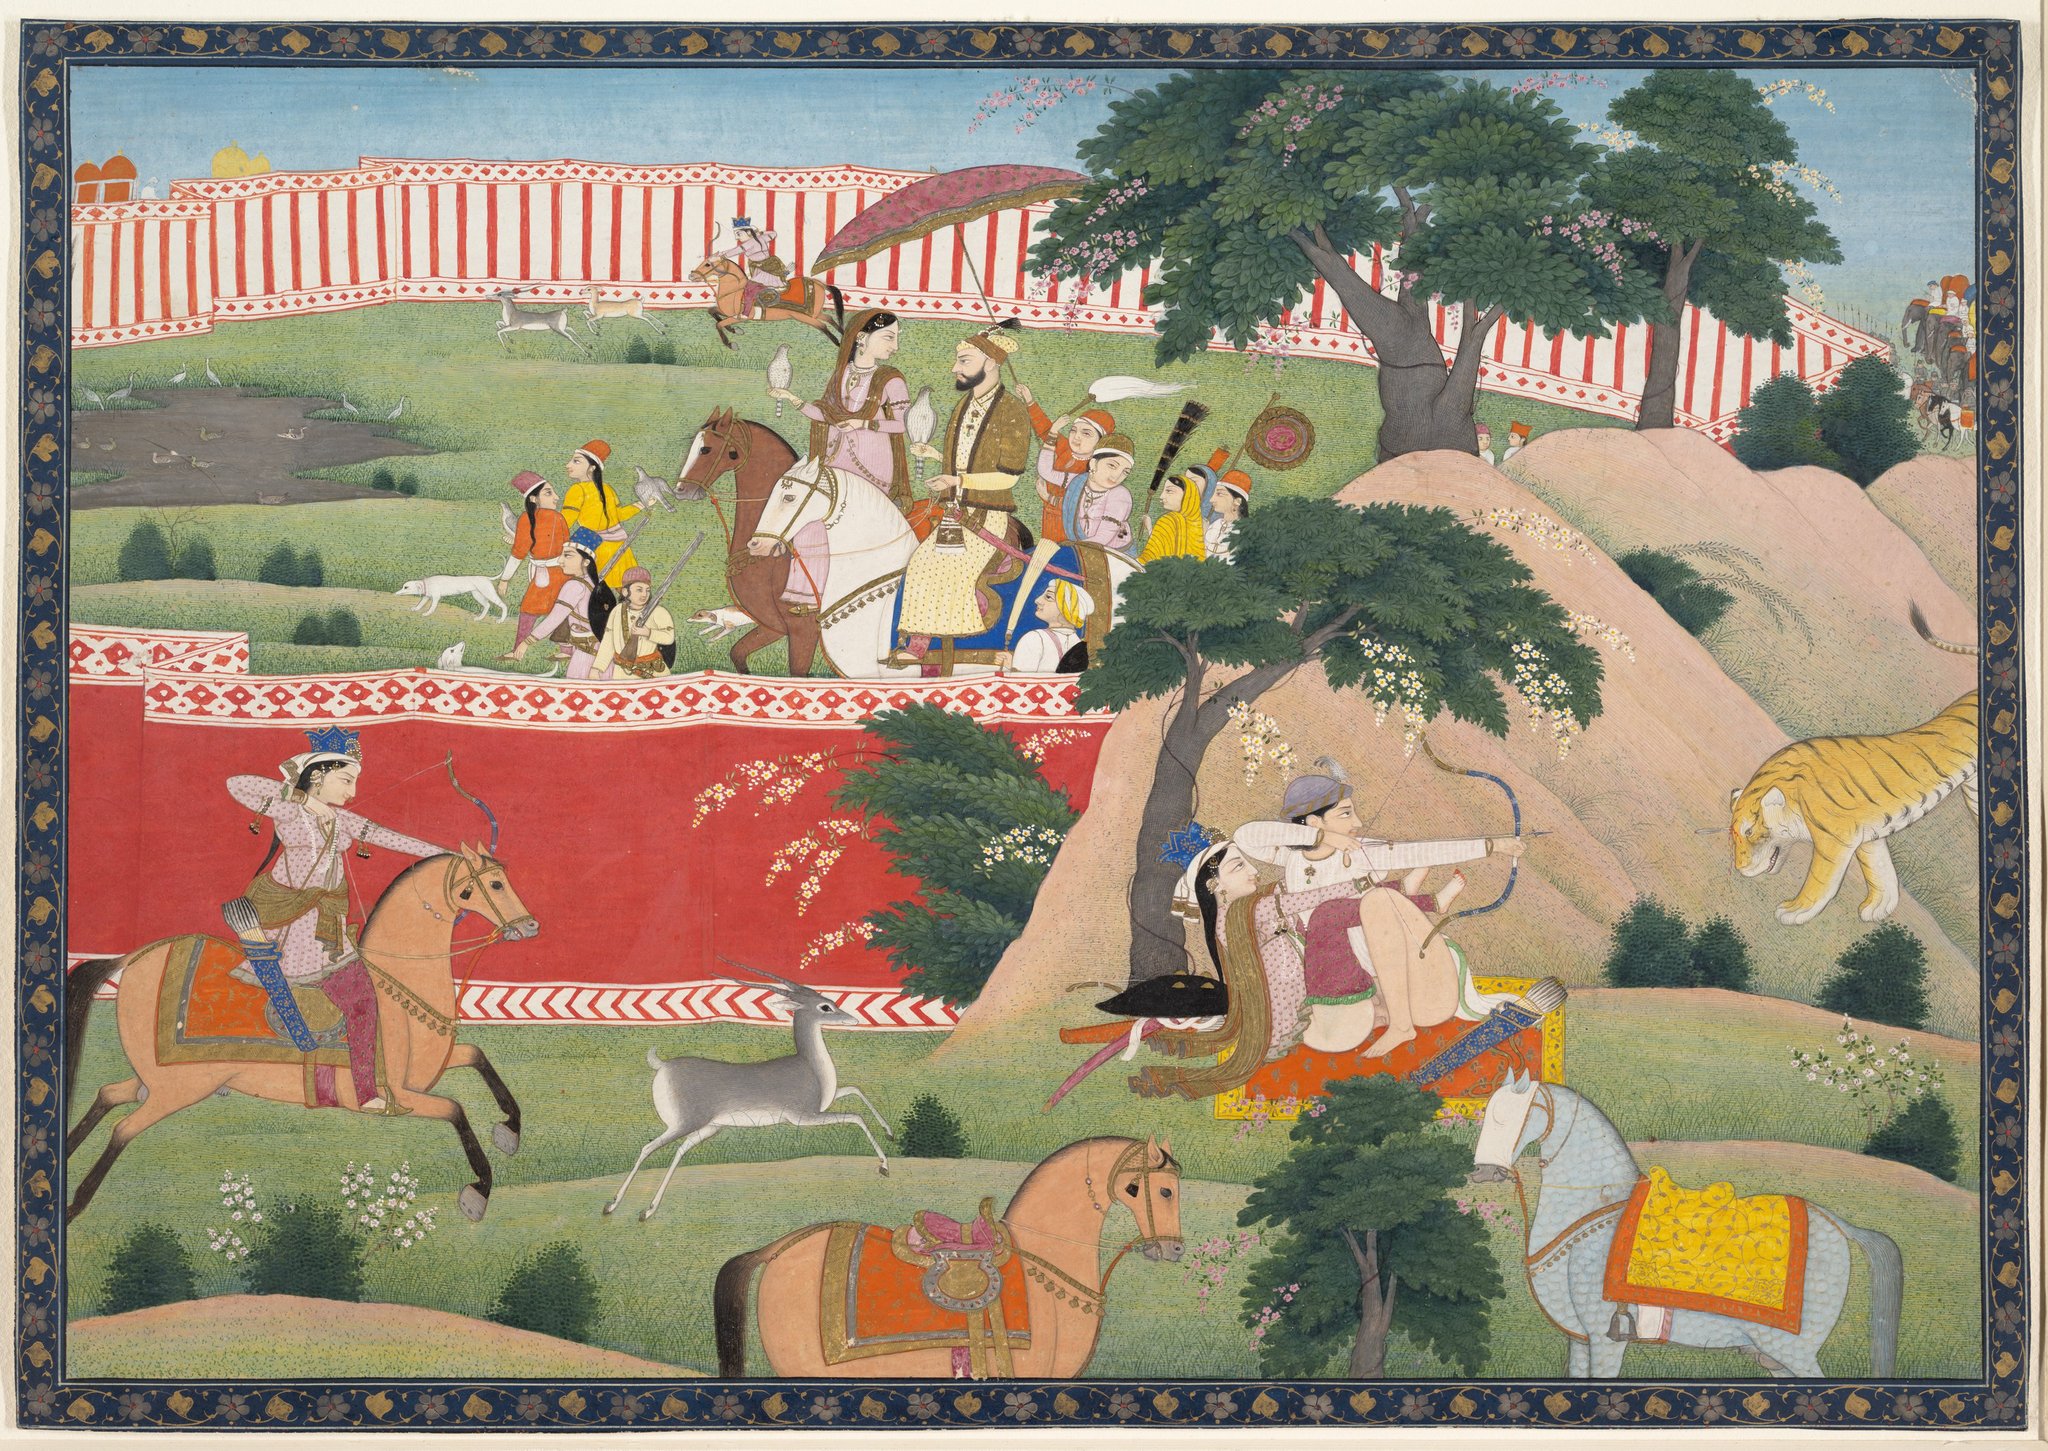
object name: painting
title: Pleasures of the Hunt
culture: indian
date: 1800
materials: gold, ink, paper, silver, watercolor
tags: hunting,deer,dogs,horses,tigers